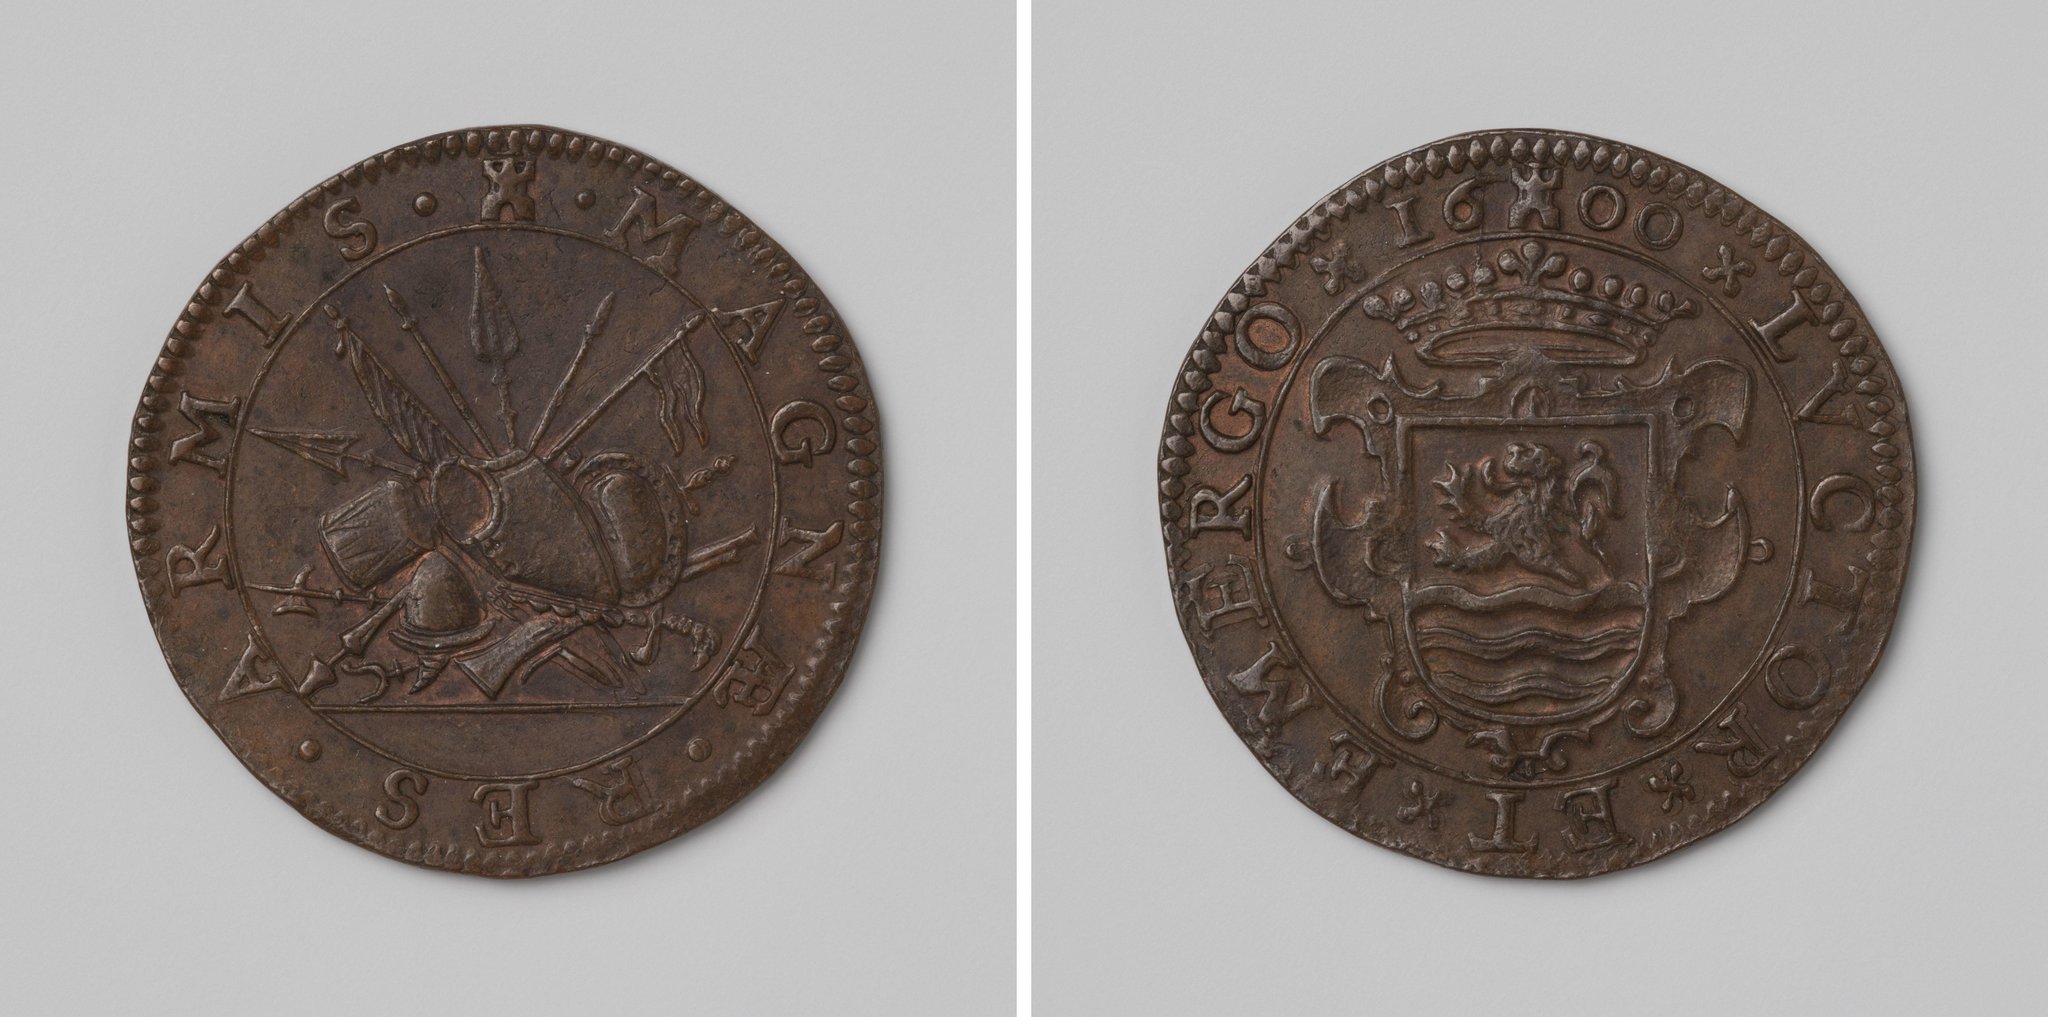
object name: jeton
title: Slag bij Nieuwpoort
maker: Anonymous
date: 1600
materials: copper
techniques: striking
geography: middelburg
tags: battle of nieuwpoort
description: Koperen penning. Voorzijde: wapentrophee binnen omschrift. Keerzijde: gekroond wapenschild in cartouche binnen omschrift